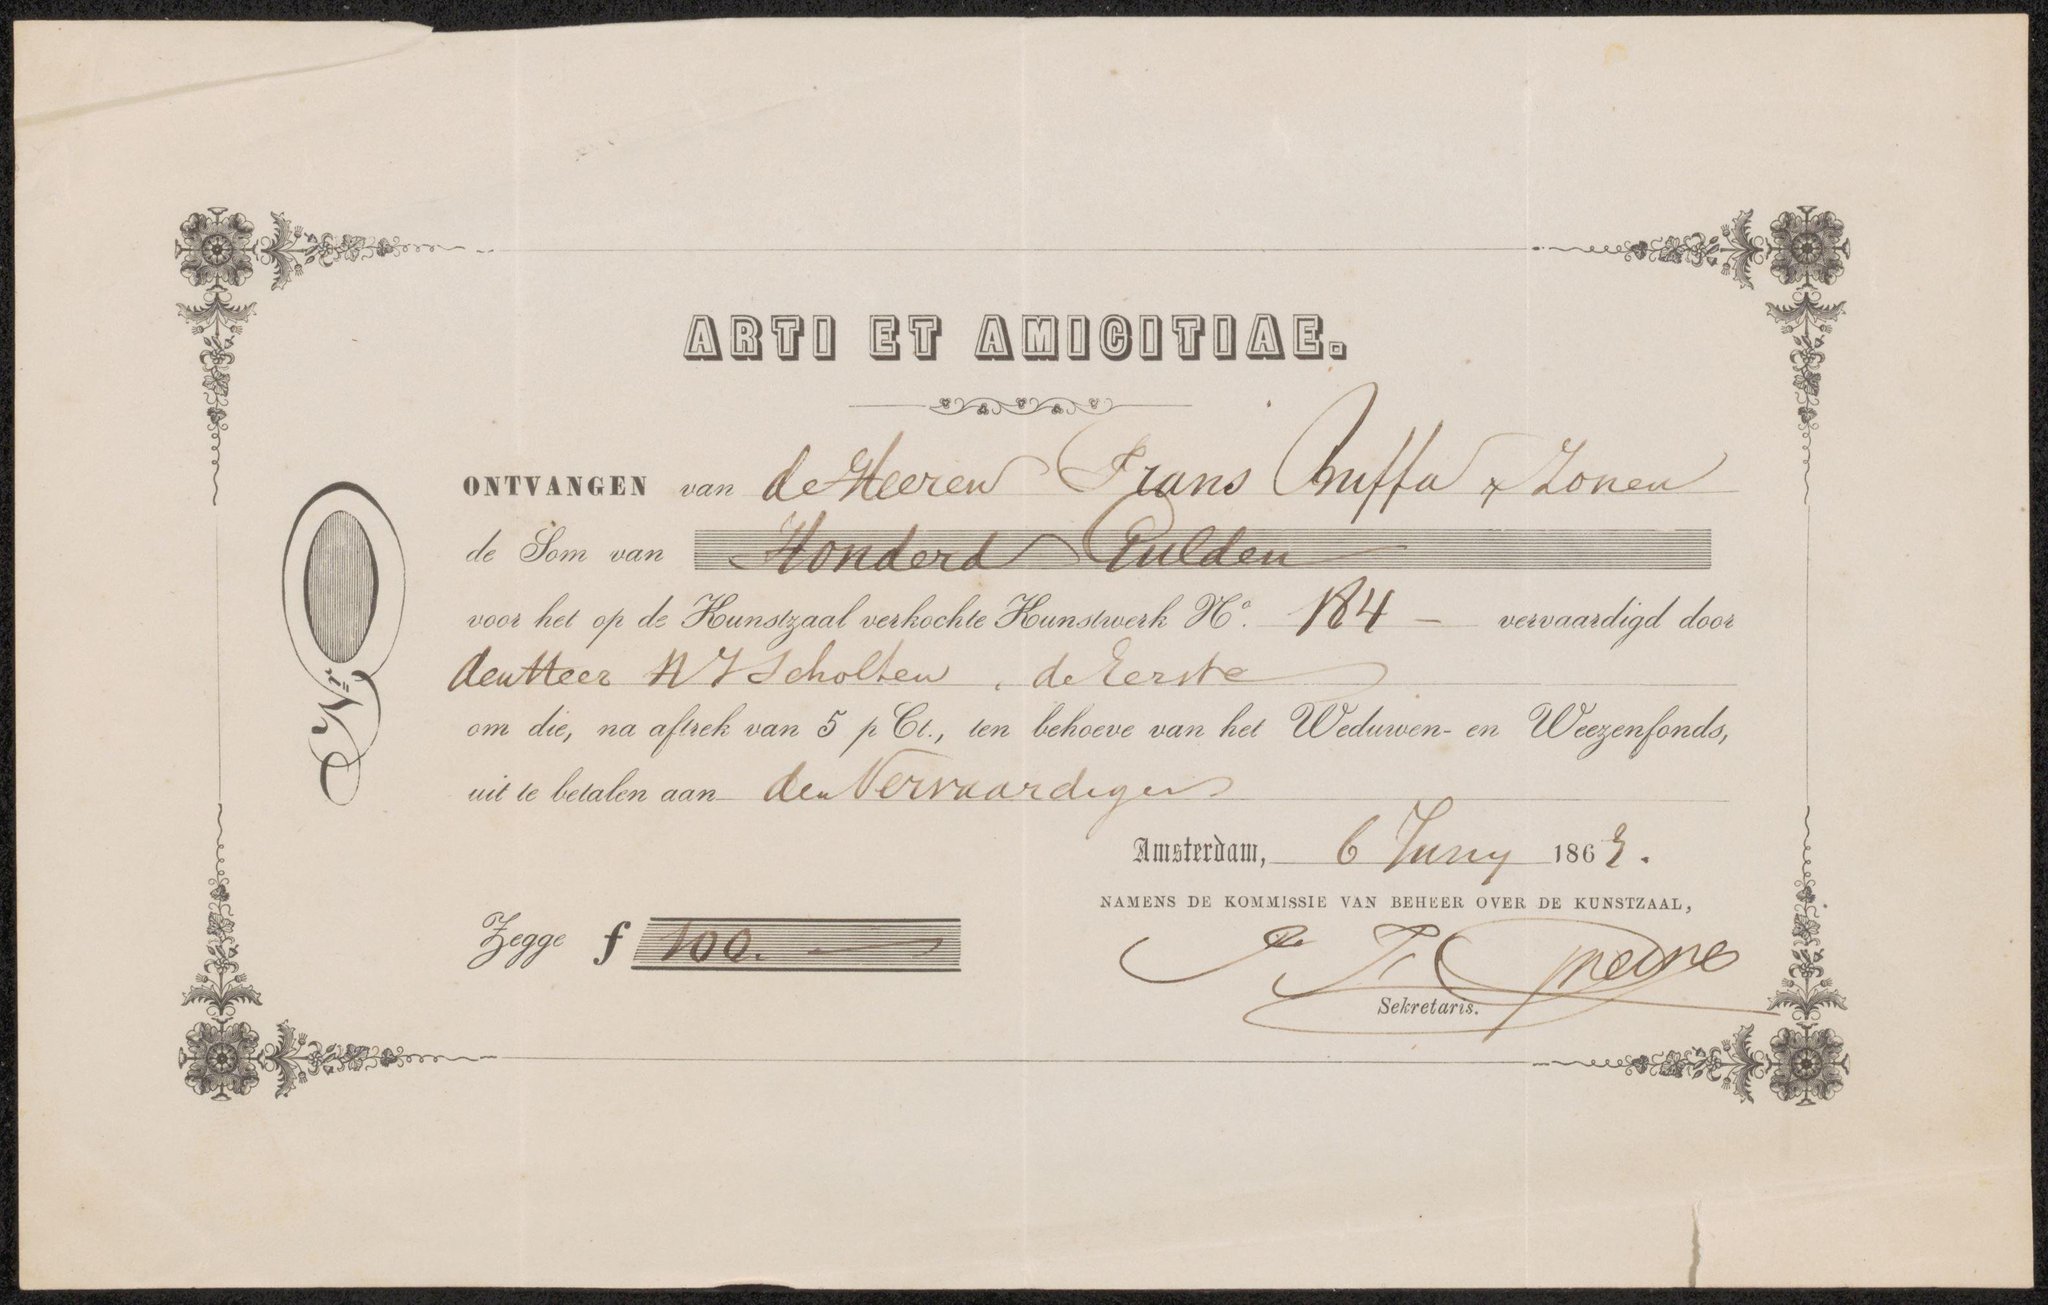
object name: ontvangstbewijs, kwitantie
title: Kwitantie voor Arti et Amicitiae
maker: petrus franciscus greive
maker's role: draughtsman, print maker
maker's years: 1811-1872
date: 1867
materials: ink, paper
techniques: pen, printing, writing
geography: amsterdam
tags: amsterdam, painter, print maker, draughtsman, hendrik jacobus scholten, money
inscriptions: collector's mark: Lugt 2233